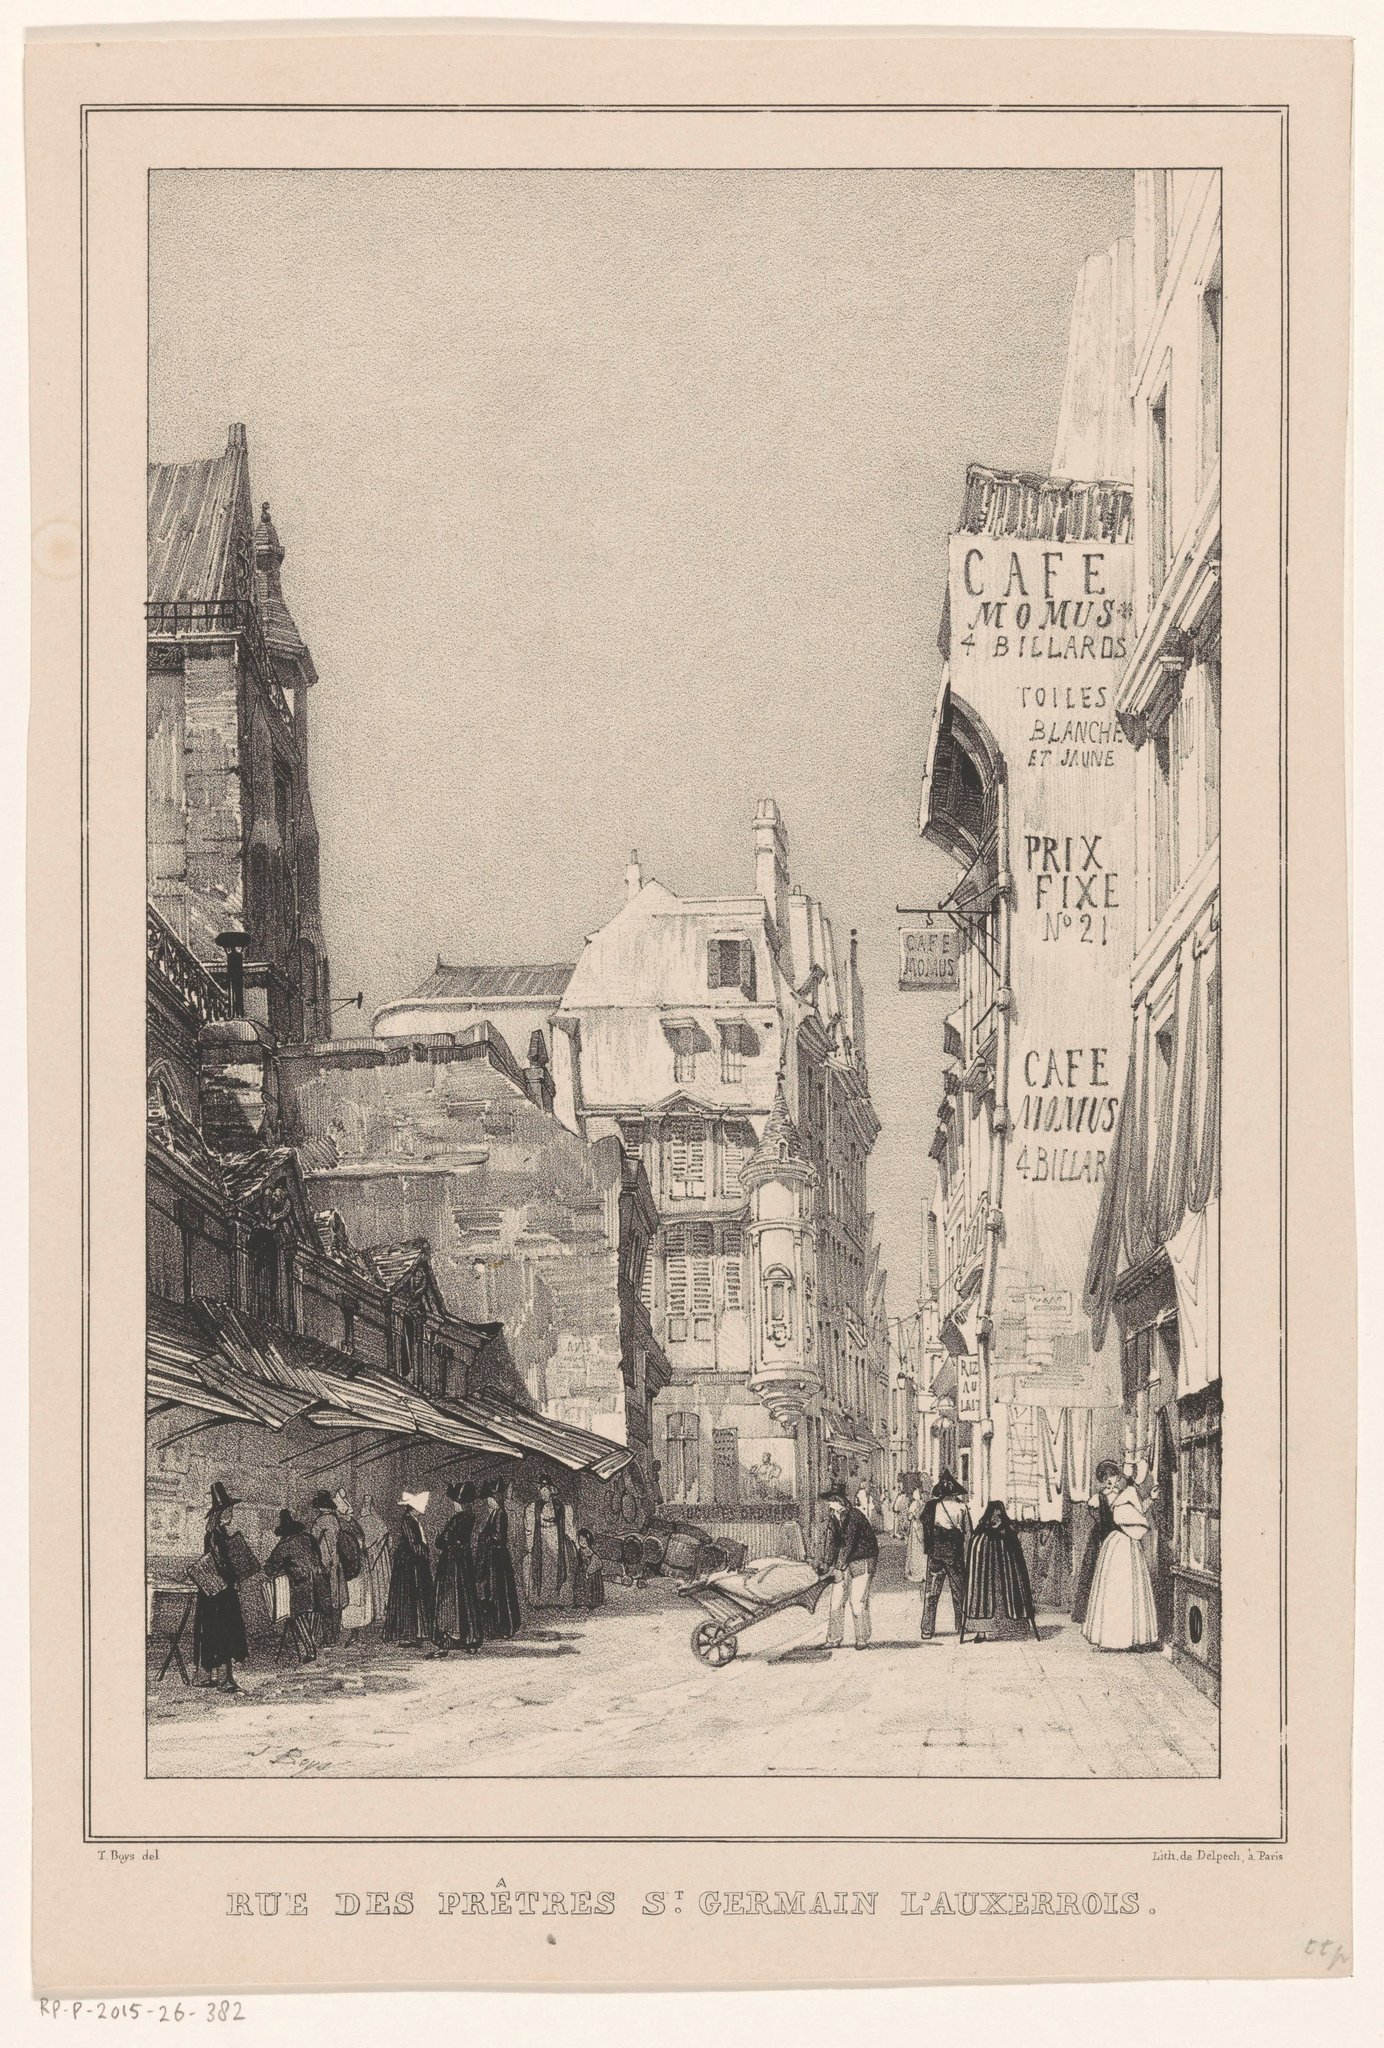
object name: print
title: Gezicht op de Rue des Prêtres-Saint-Germain-l'Auxerrois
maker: veuve delpech (naudet)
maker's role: drukkerij, uitgeverij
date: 1818-1825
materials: paper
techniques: lithograph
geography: paris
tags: street-trader, city-view in general; 'veduta' (+ city(-scape) with figures, staffage)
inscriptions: collector's mark: Lugt 2228, collector's mark: Lugt 4780, collector's mark: Lugt 4779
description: Aan de linkerzijde van de straat stalletjes van boek- of prentverkopers onder een overkapping bevestigd aan de buitenmuur van de Saint-Germain-l'Auxerrois, aan de rechterzijde café Momus.